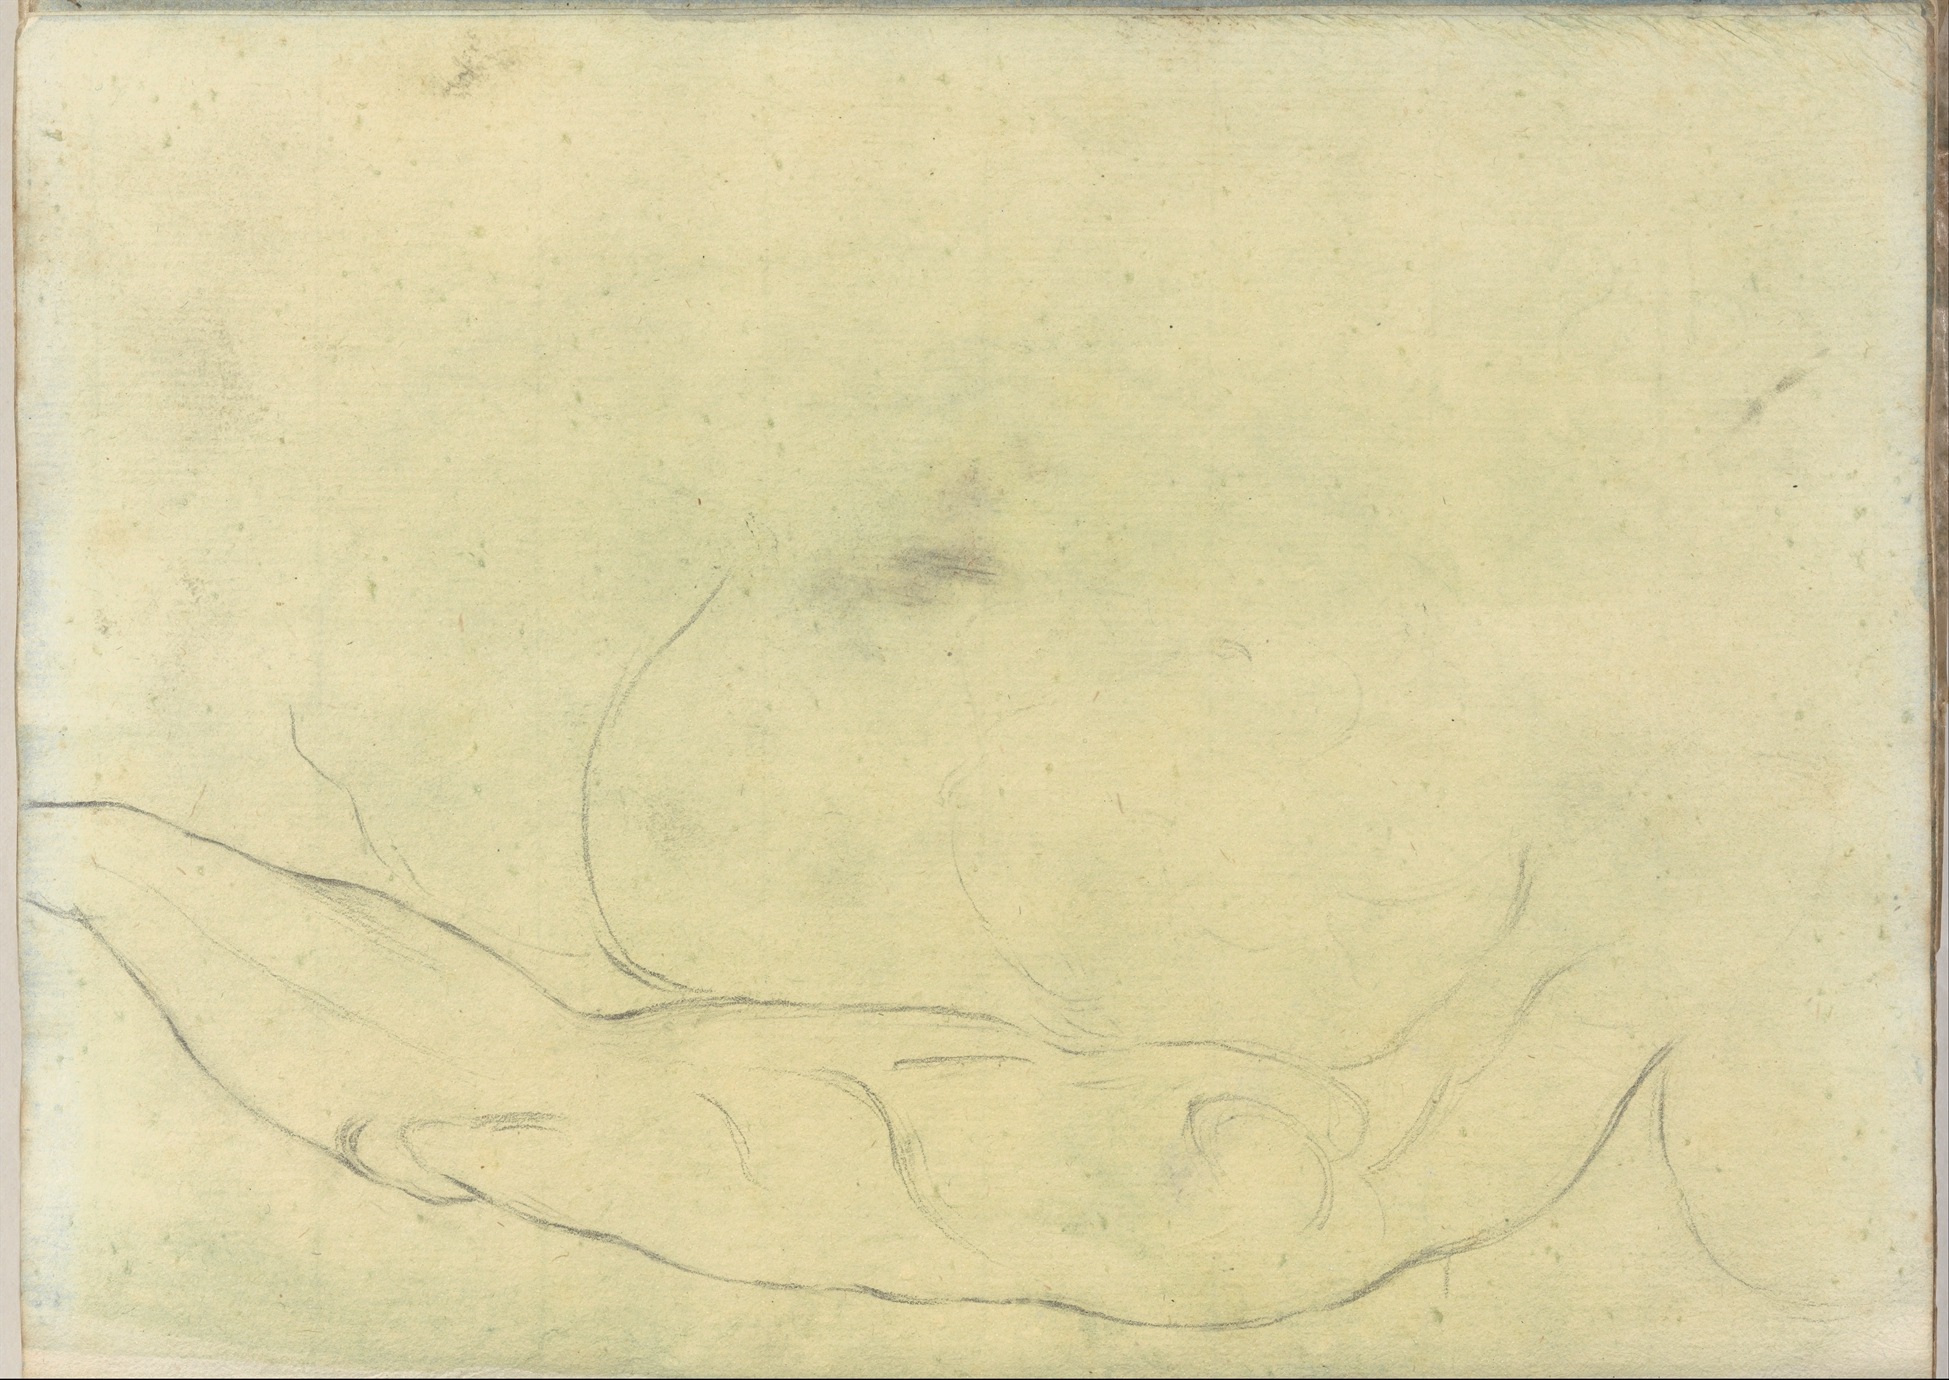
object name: drawing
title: Sketches of male bodies, after Michelangeolo (?) (Smaller Italian sketchbook, leaf 18 recto)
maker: joseph wright (wright of derby)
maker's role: artist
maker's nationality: british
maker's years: 1734-1797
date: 1774-1775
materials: graphite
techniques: brush, wash